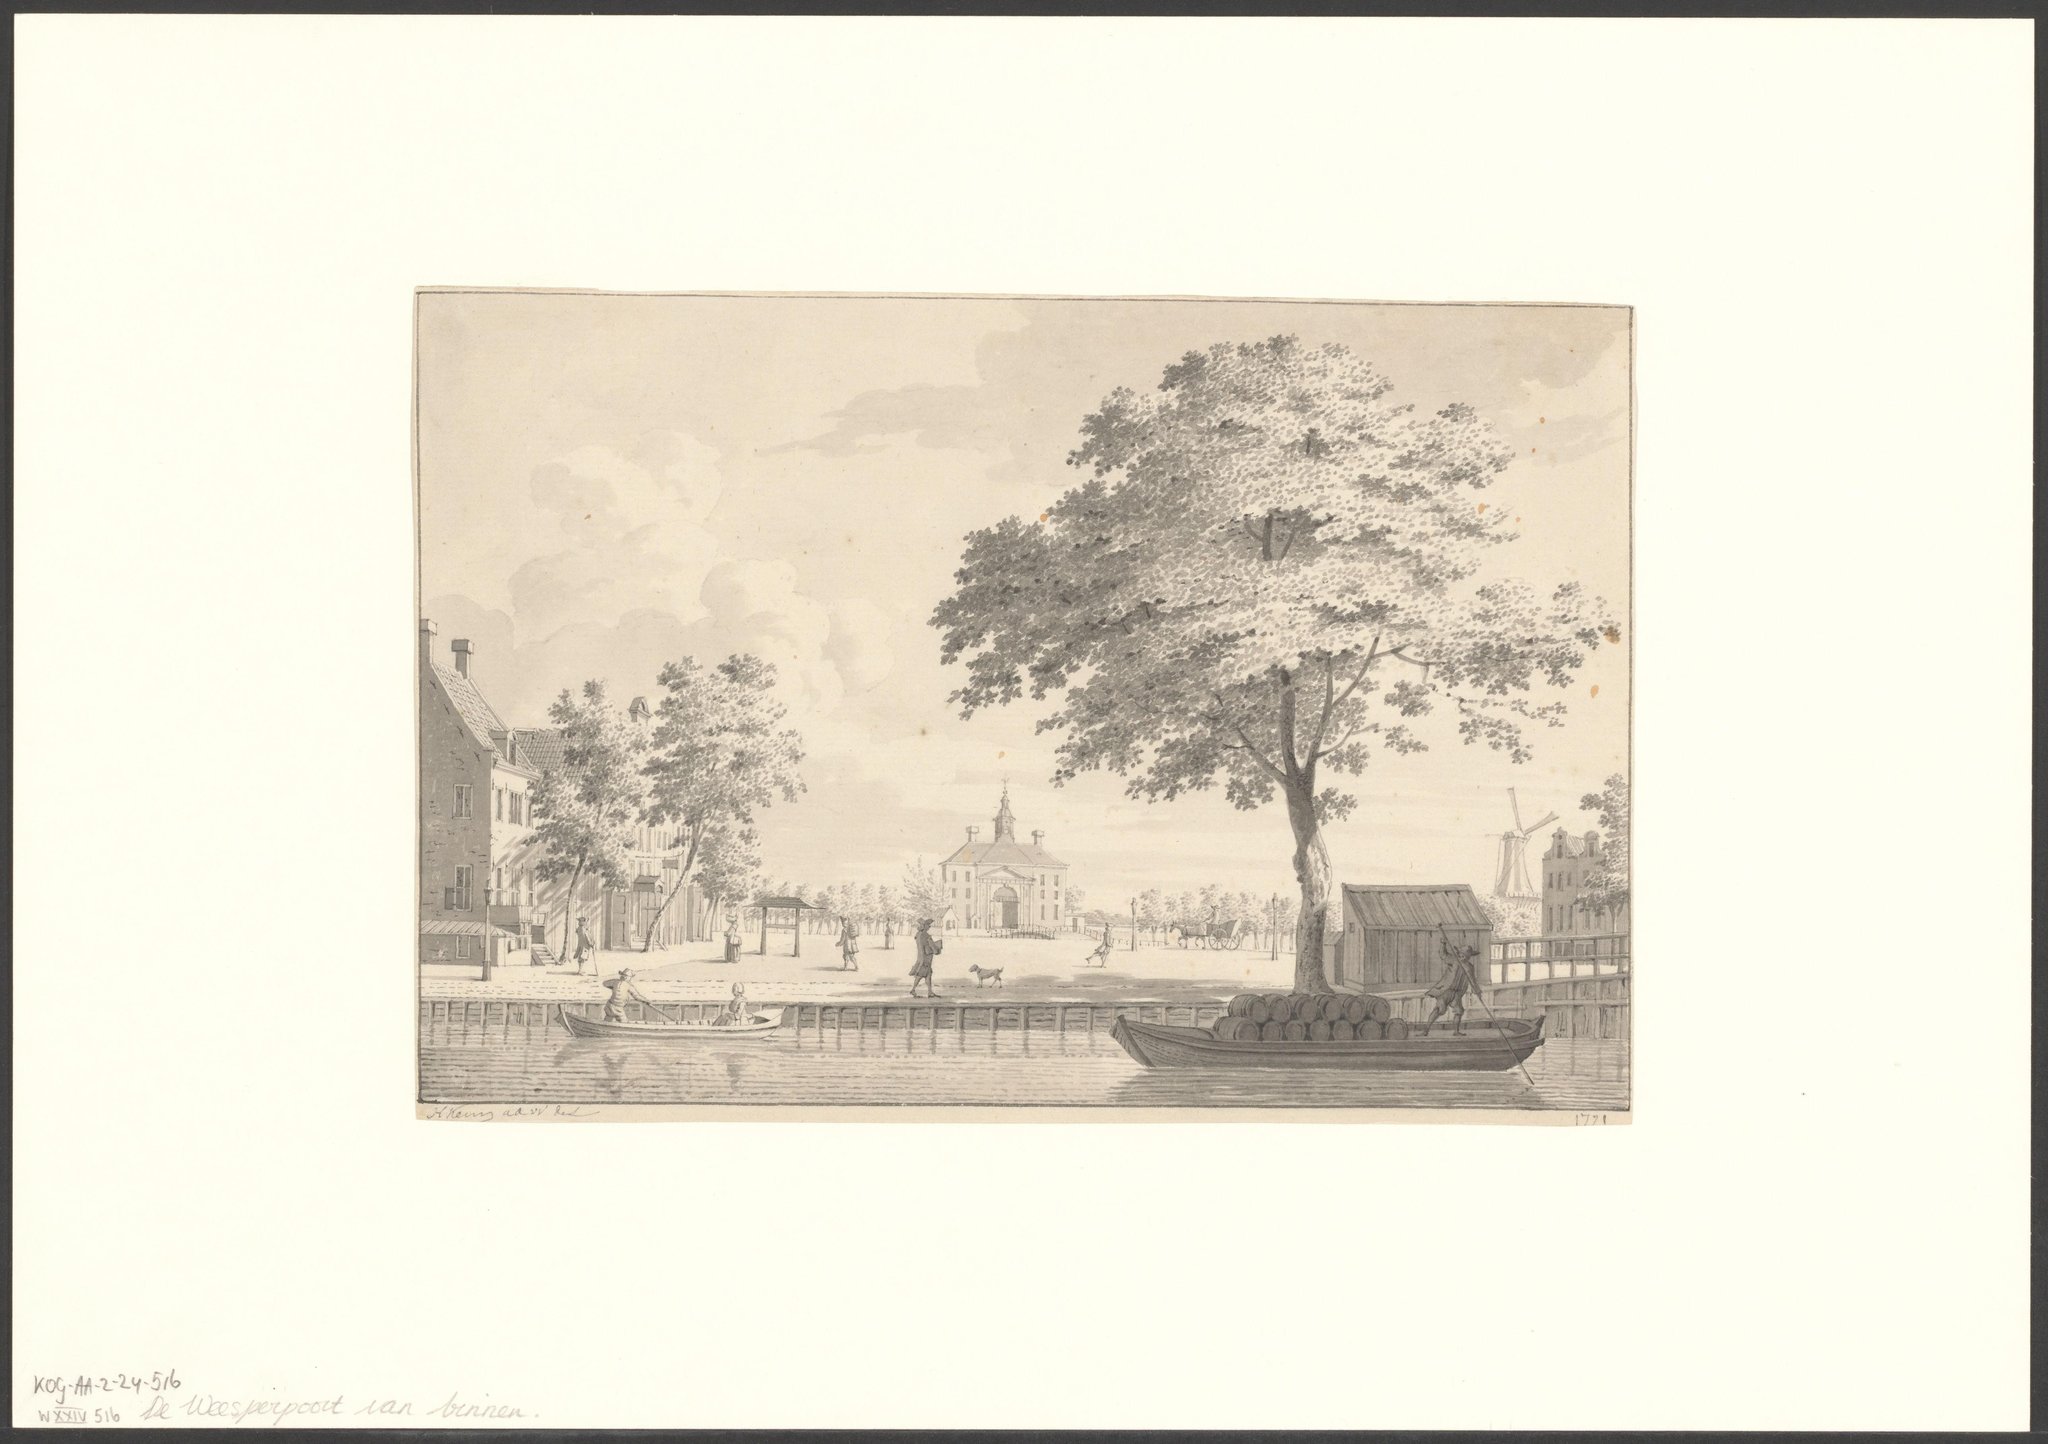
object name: drawing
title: Gezicht op het Weesperplein en de Weesperpoort vanaf de Nieuwe Achtergracht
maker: hendrik keun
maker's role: painter, print maker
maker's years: 1738-1787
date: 1771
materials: ink, paper, pencil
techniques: brush, pen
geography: amsterdam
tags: city-view in general; 'veduta', canal, city-gate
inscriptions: collector's mark: Lugt 800a, signature and date: ‘HKeune ad viv del / 1771’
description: Tekening binnen de Atlas Van Eck ingedeeld op wijknummer 24.